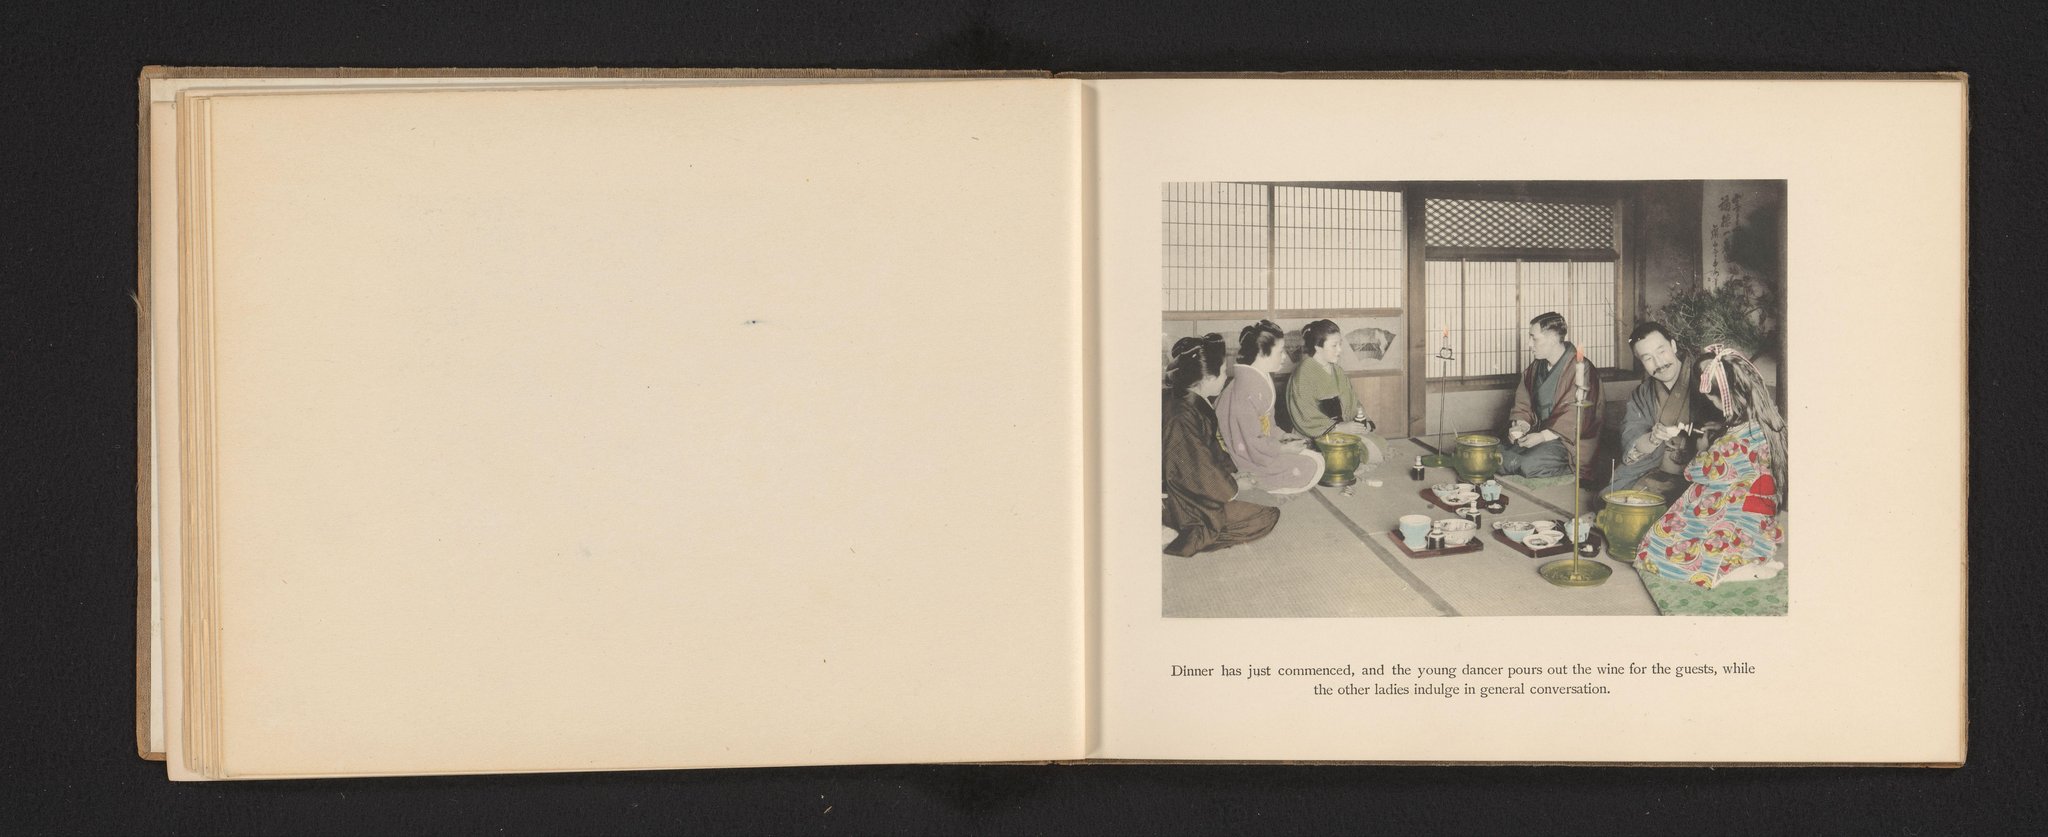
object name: photomechanical print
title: Vier geisha's vergezellen twee mannen tijdens het eten in een theehuis in Japan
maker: kōzaburō tamamura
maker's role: fotograaf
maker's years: 1856-1923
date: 1896-1906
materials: paper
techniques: photograph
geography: japan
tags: performance (+ artist in non-work situation), tea garden, garden restaurant, japan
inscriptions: inscription: ‘Dinner has just commenced, and the young dancer pours out the wine for the guests, while the other ladies indulge in general conversation.’